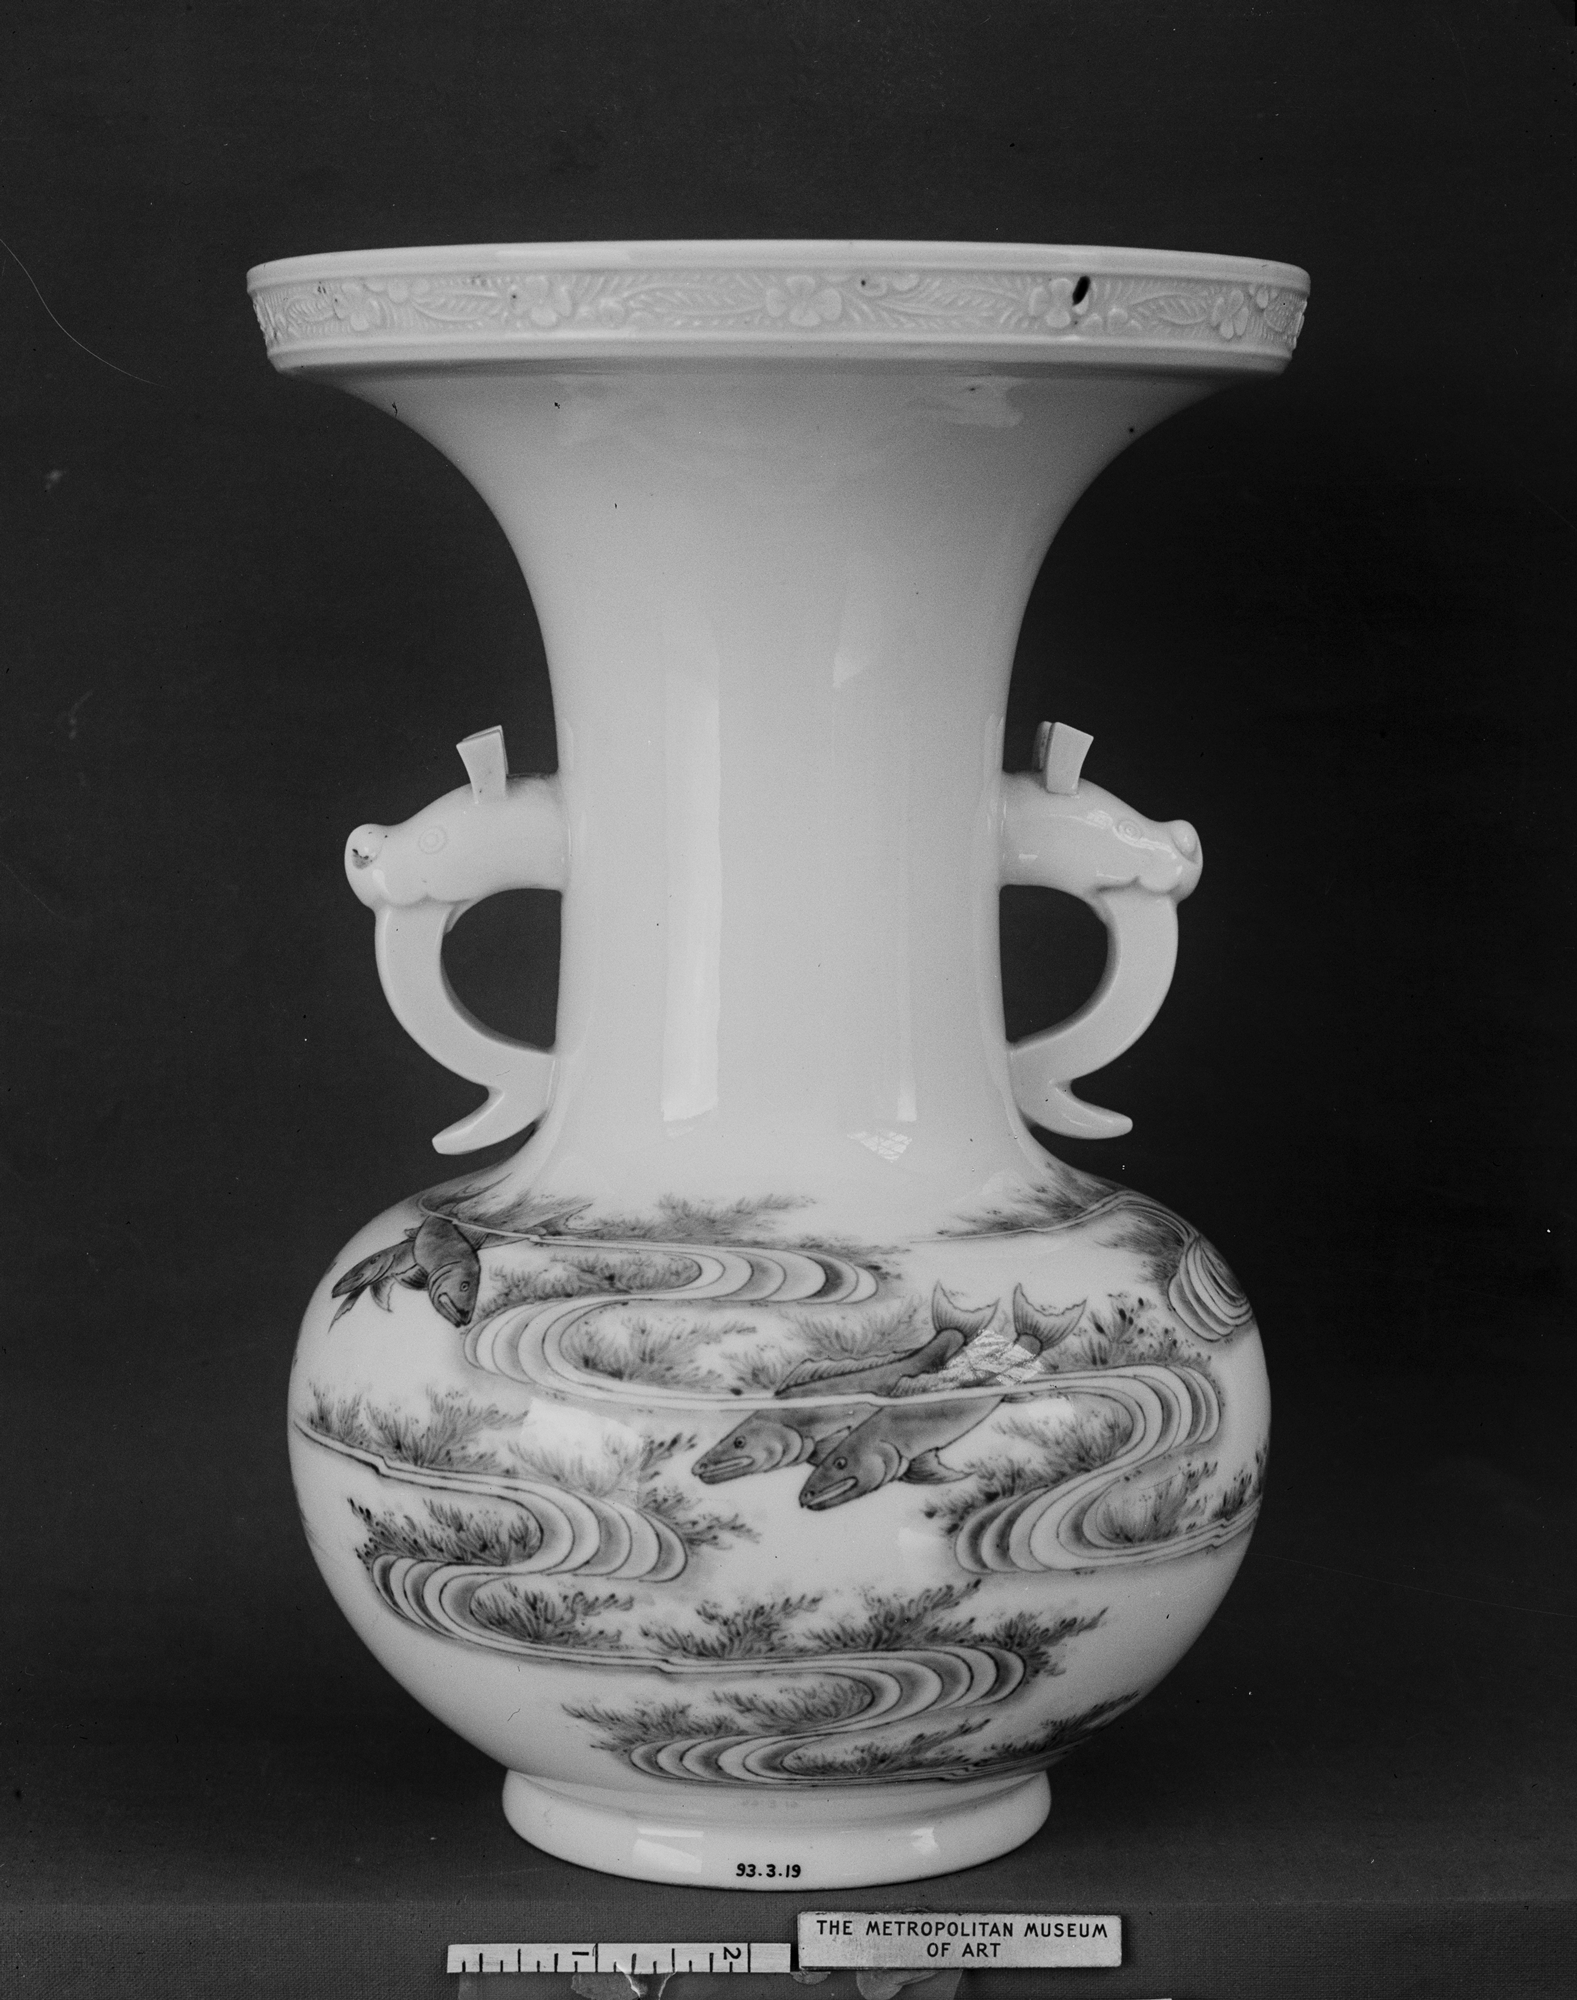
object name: vase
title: Wide-Mouth Vase with Carp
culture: japanese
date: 1834-1866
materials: porcelain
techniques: underglaze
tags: fish